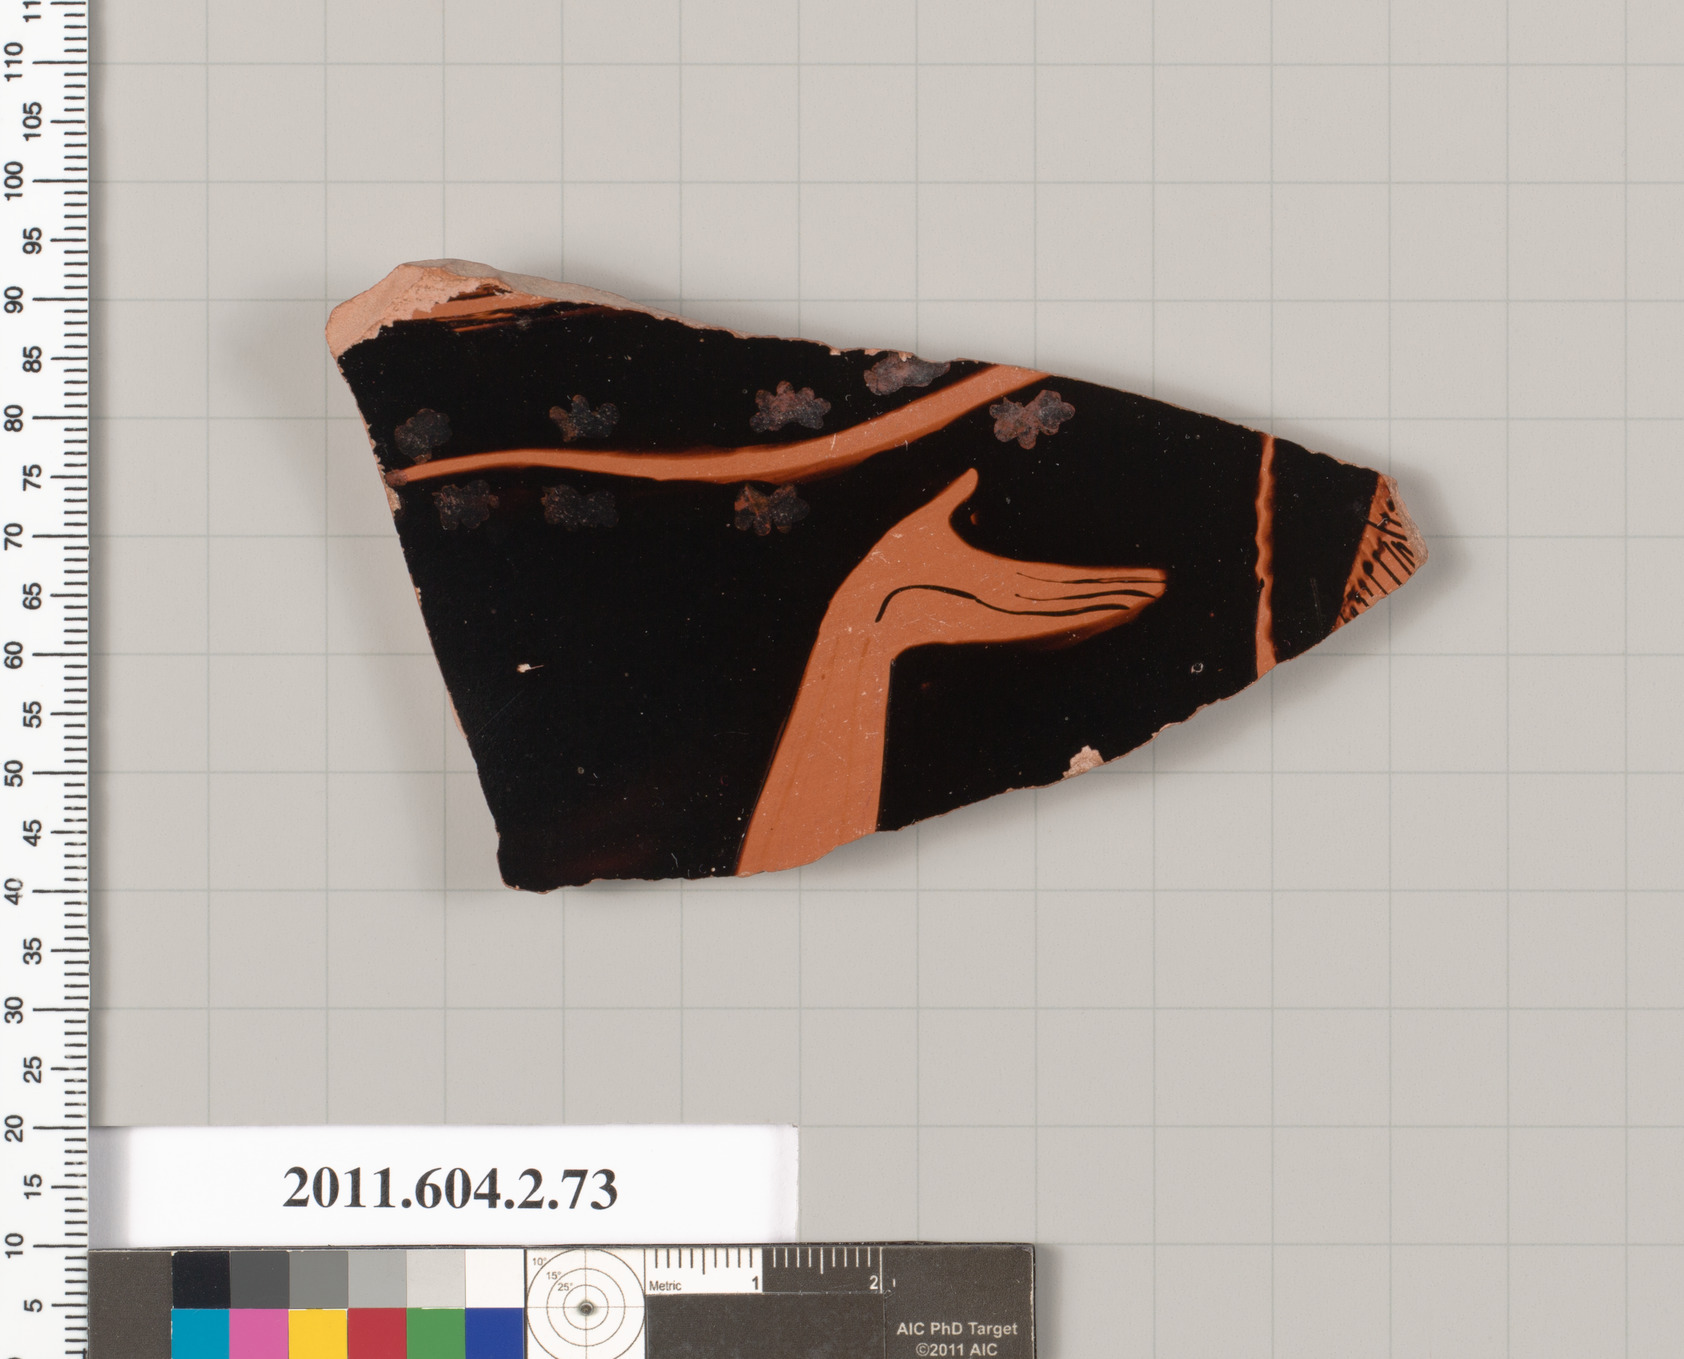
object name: amphora fragment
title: Terracotta fragment of an amphora (jar)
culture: greek, attic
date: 500-480 BCE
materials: terracotta